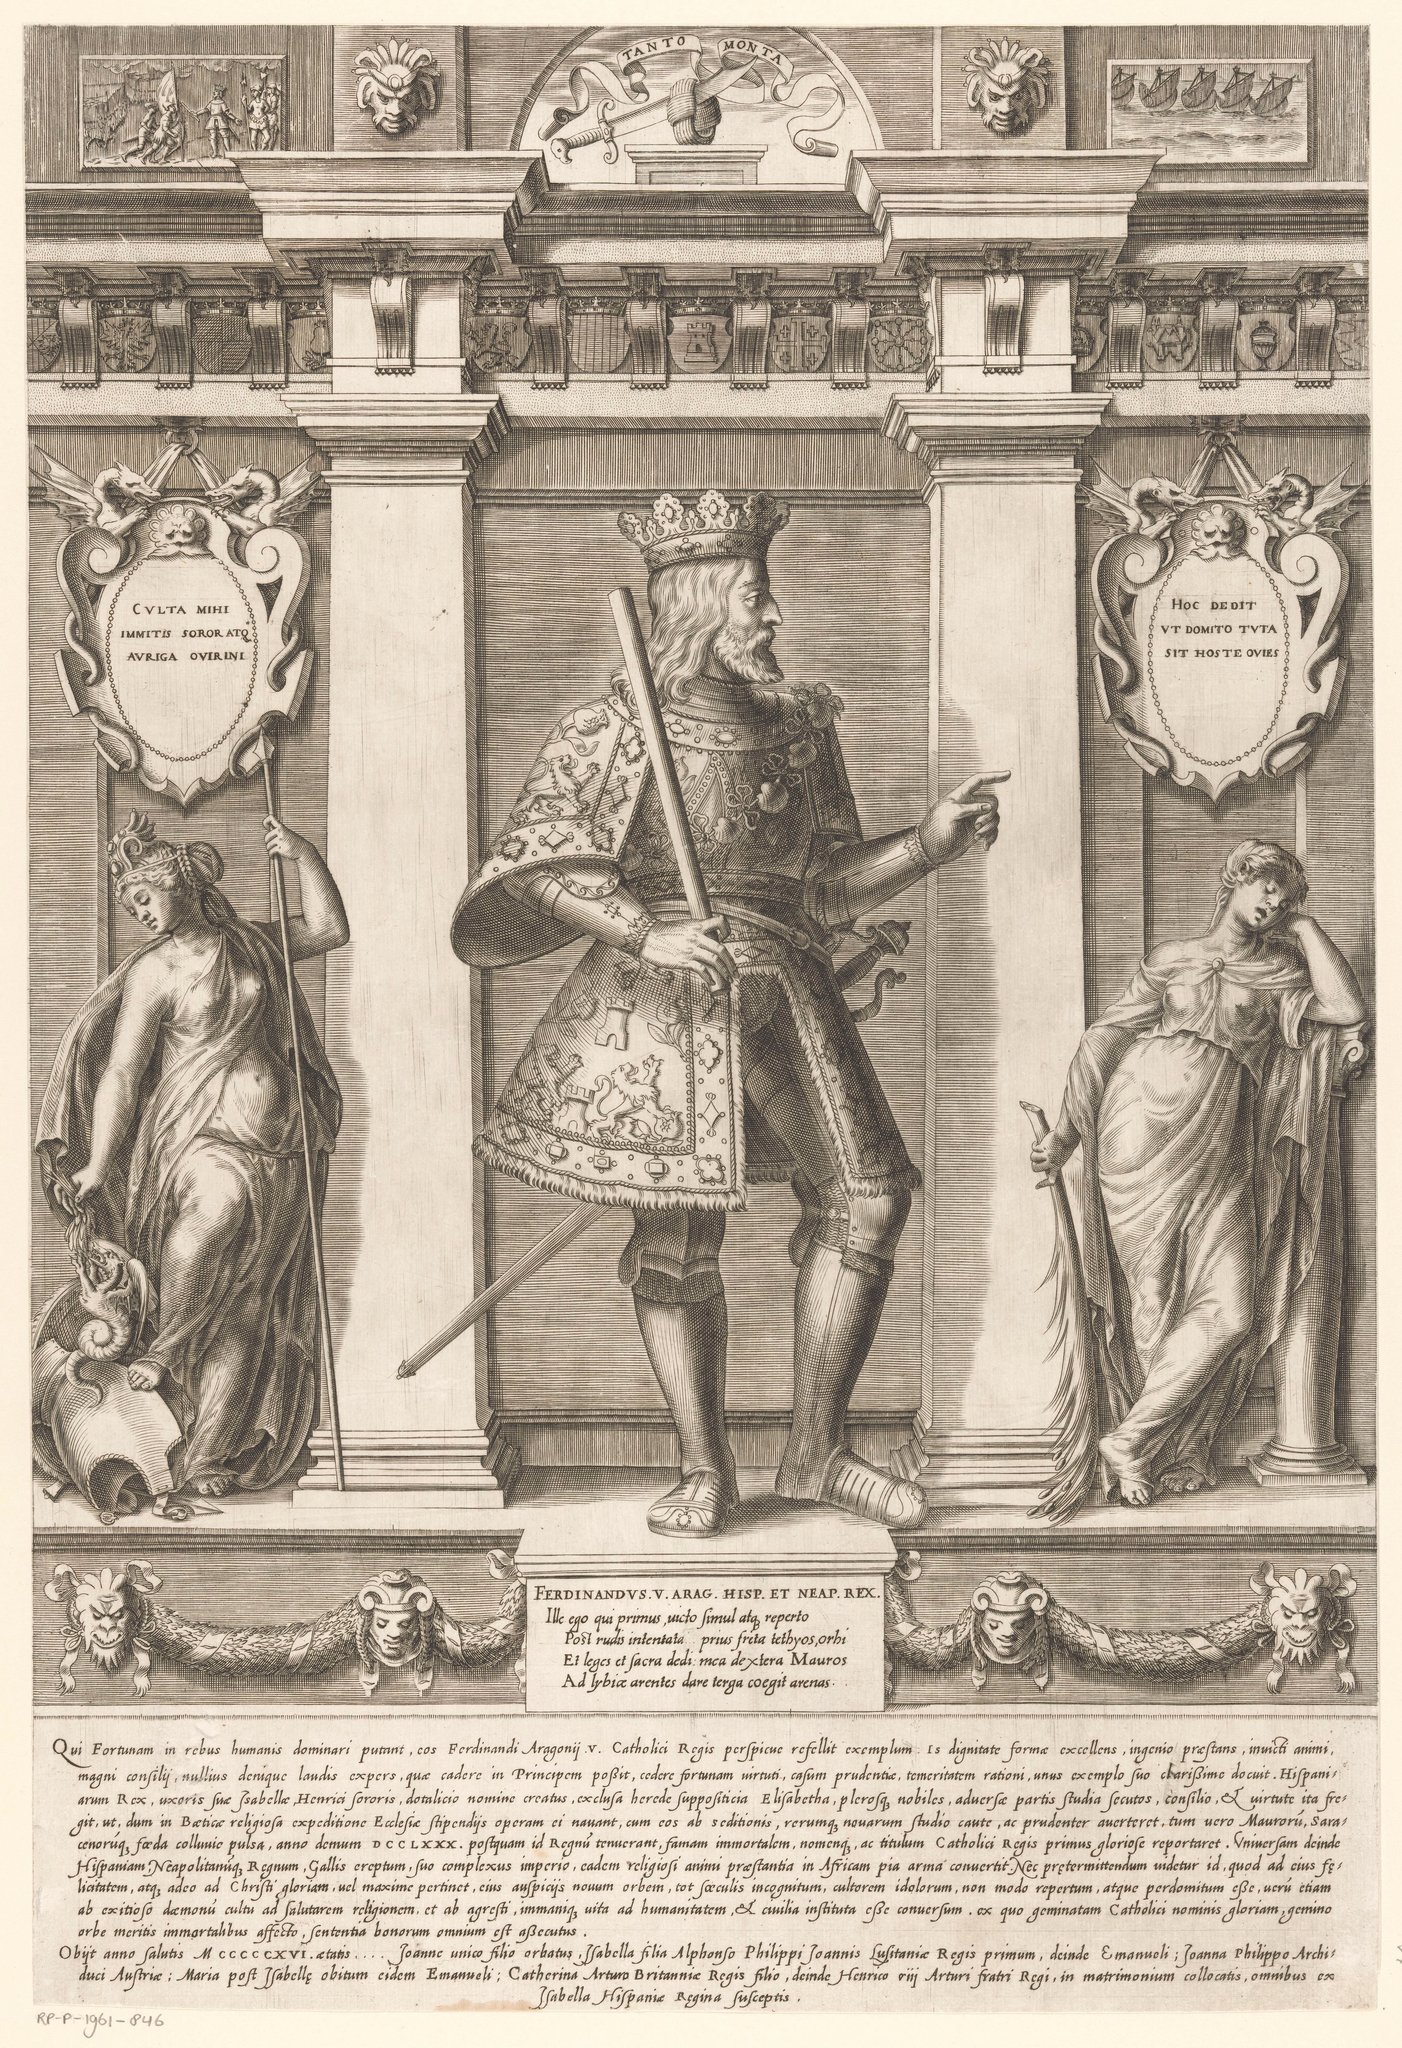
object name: print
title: Austriacae gentis imaginum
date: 1569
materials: paper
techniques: engraving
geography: italy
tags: historical persons, ruler, sovereign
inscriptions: collector's mark: Lugt 2228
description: Deze prent maakt deel uit van een reeks van 58 prenten. Het meerendeel van de prenten bevat portretten van 74 leden van het Oostenrijkse Huis, naar tekeningen door Francesco Terzio, die deels getekend zijn naar de 28 levensgrote bronzen beelden die rond de cenotaaf van Maximiliaan I in de Hofkirche te Innsbruck staan.